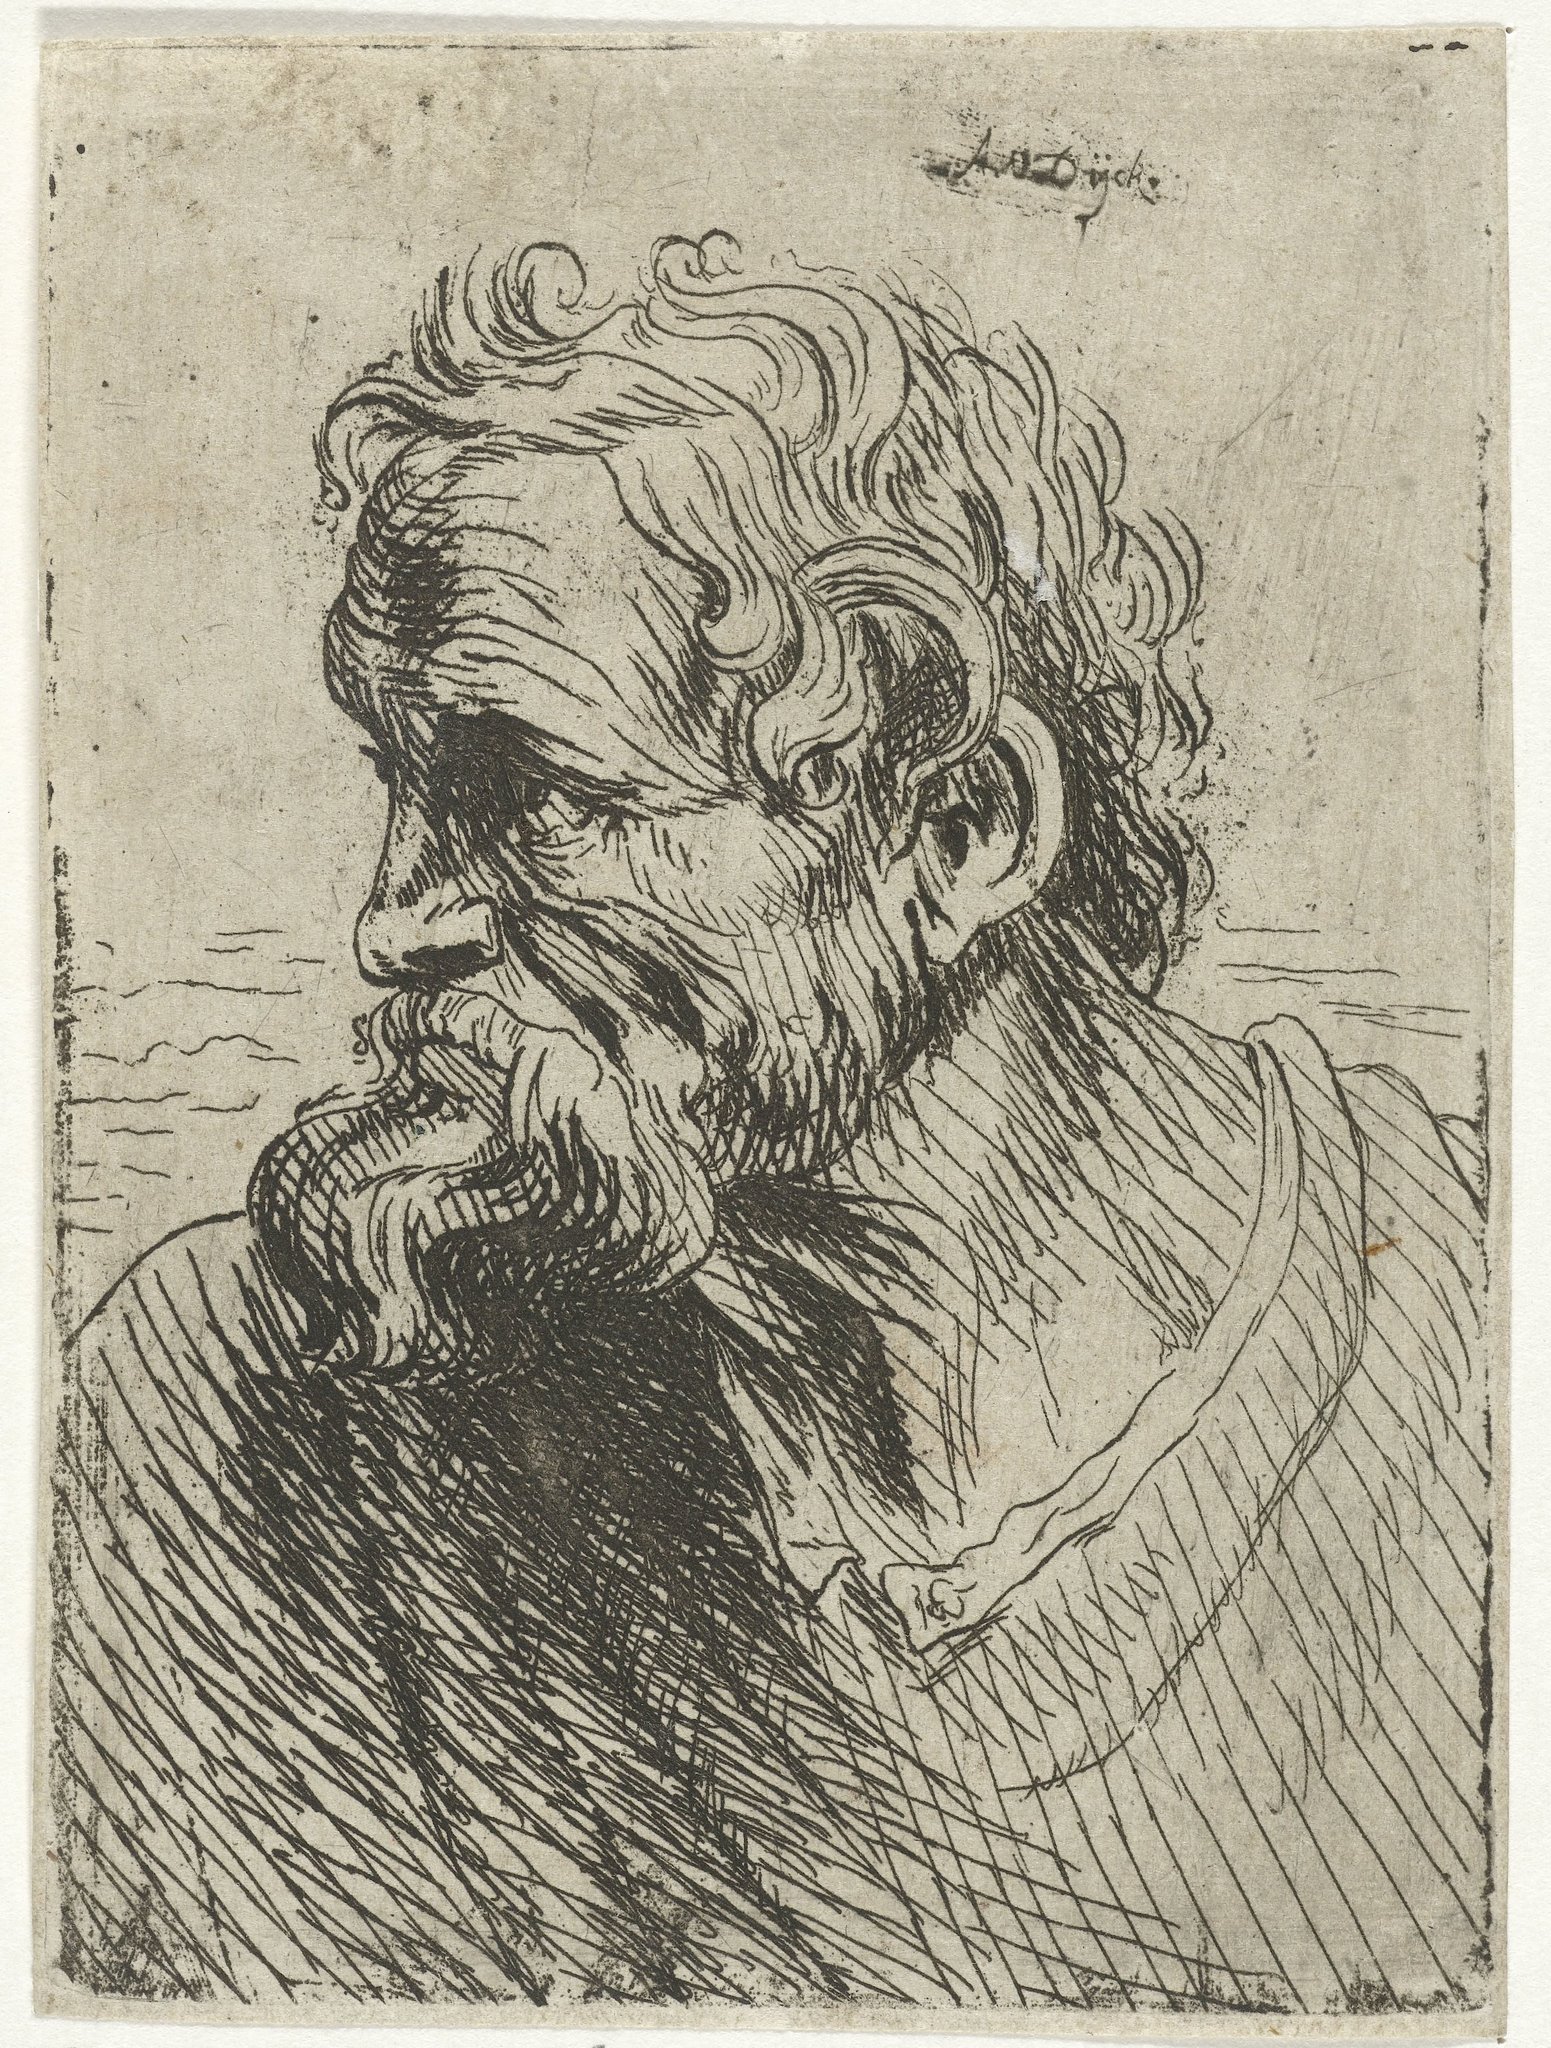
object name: print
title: Kop van een oude man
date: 1626-1681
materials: paper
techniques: etching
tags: old man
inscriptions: collector's mark: Lugt 2165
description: Kop van een oude man met baard, het hoofd is naar links gekeerd.